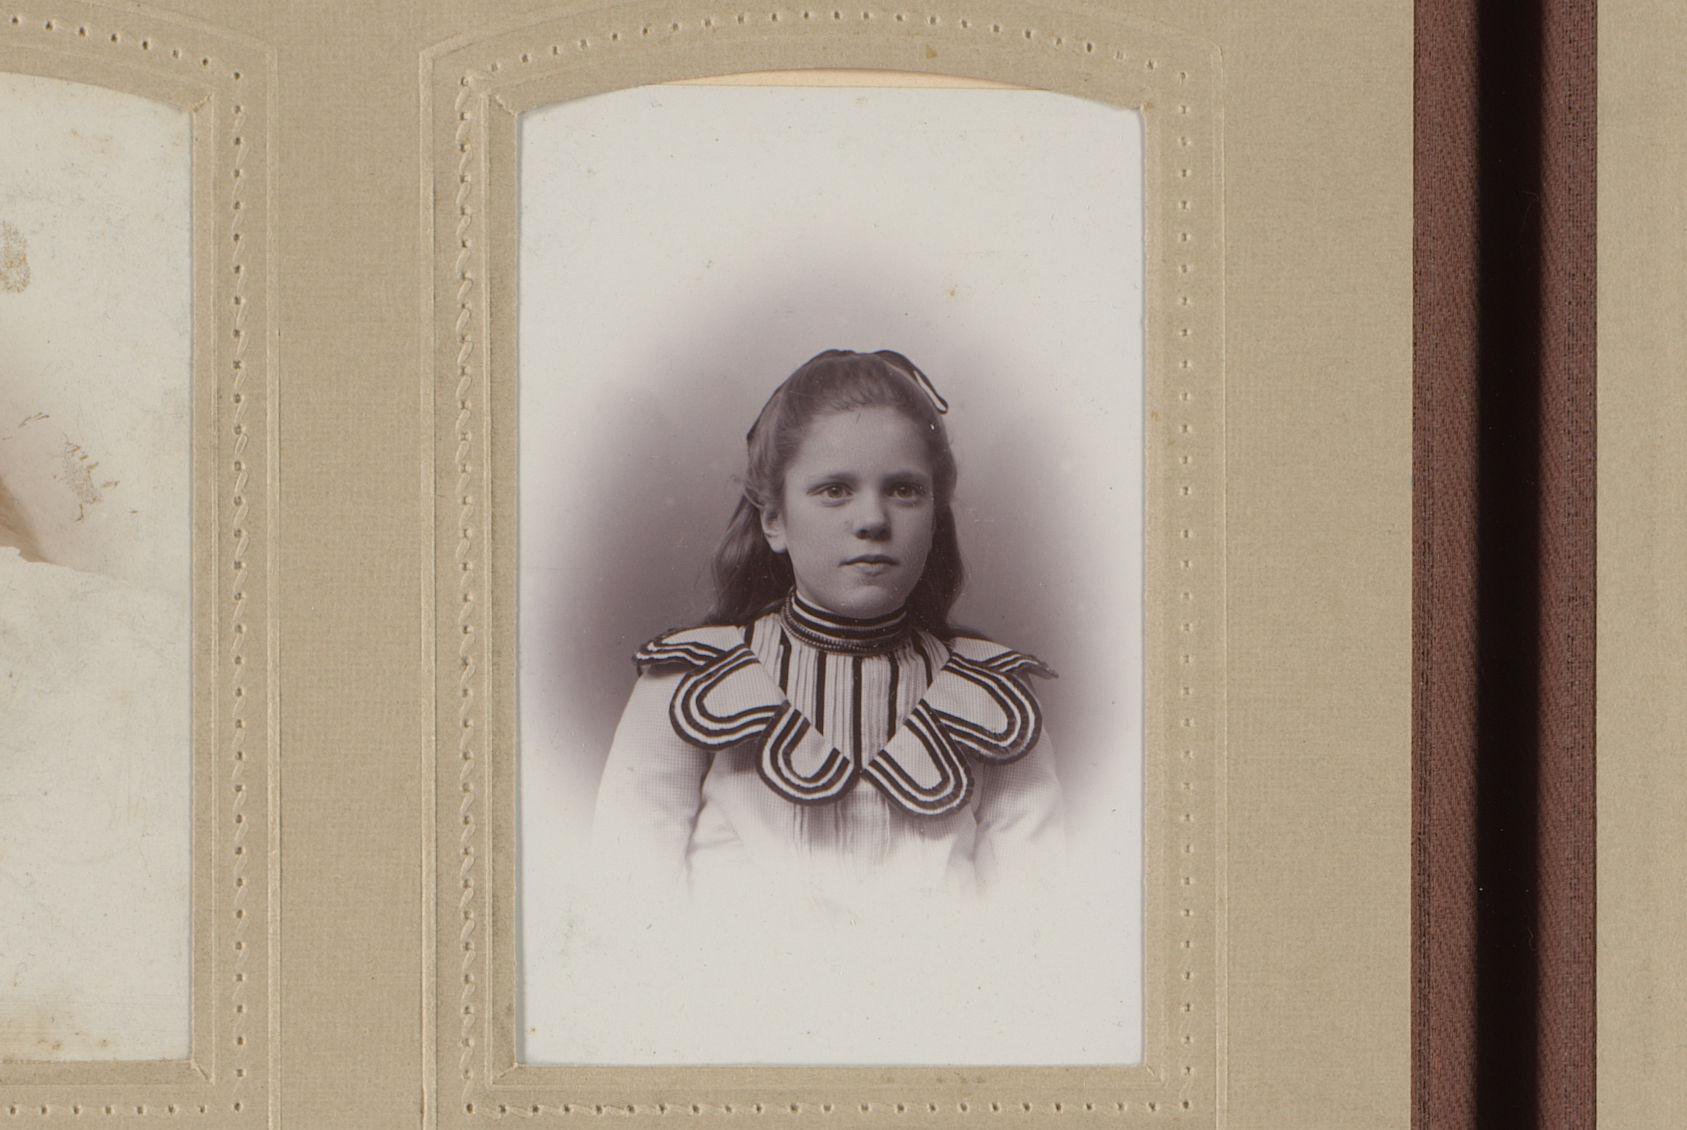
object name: photograph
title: Studioportret van een meisje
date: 1890-1900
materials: paper, photographic support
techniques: collodion silver print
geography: netherlands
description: Onderdeel van overdracht foto's en albums van familie Kessler-de Lange.